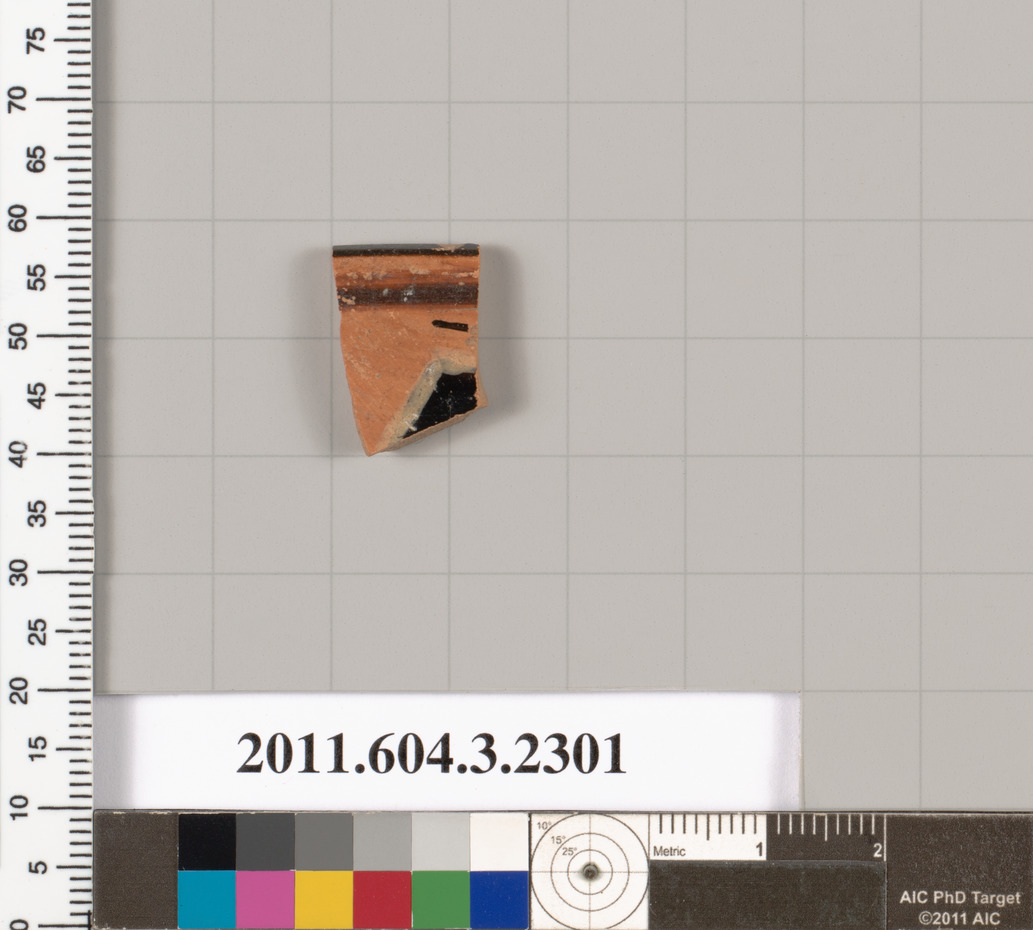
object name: kylix fragment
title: Terracotta rim fragment of a kylix: eye-cup (drinking cup)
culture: greek, attic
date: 530-510 BCE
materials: terracotta